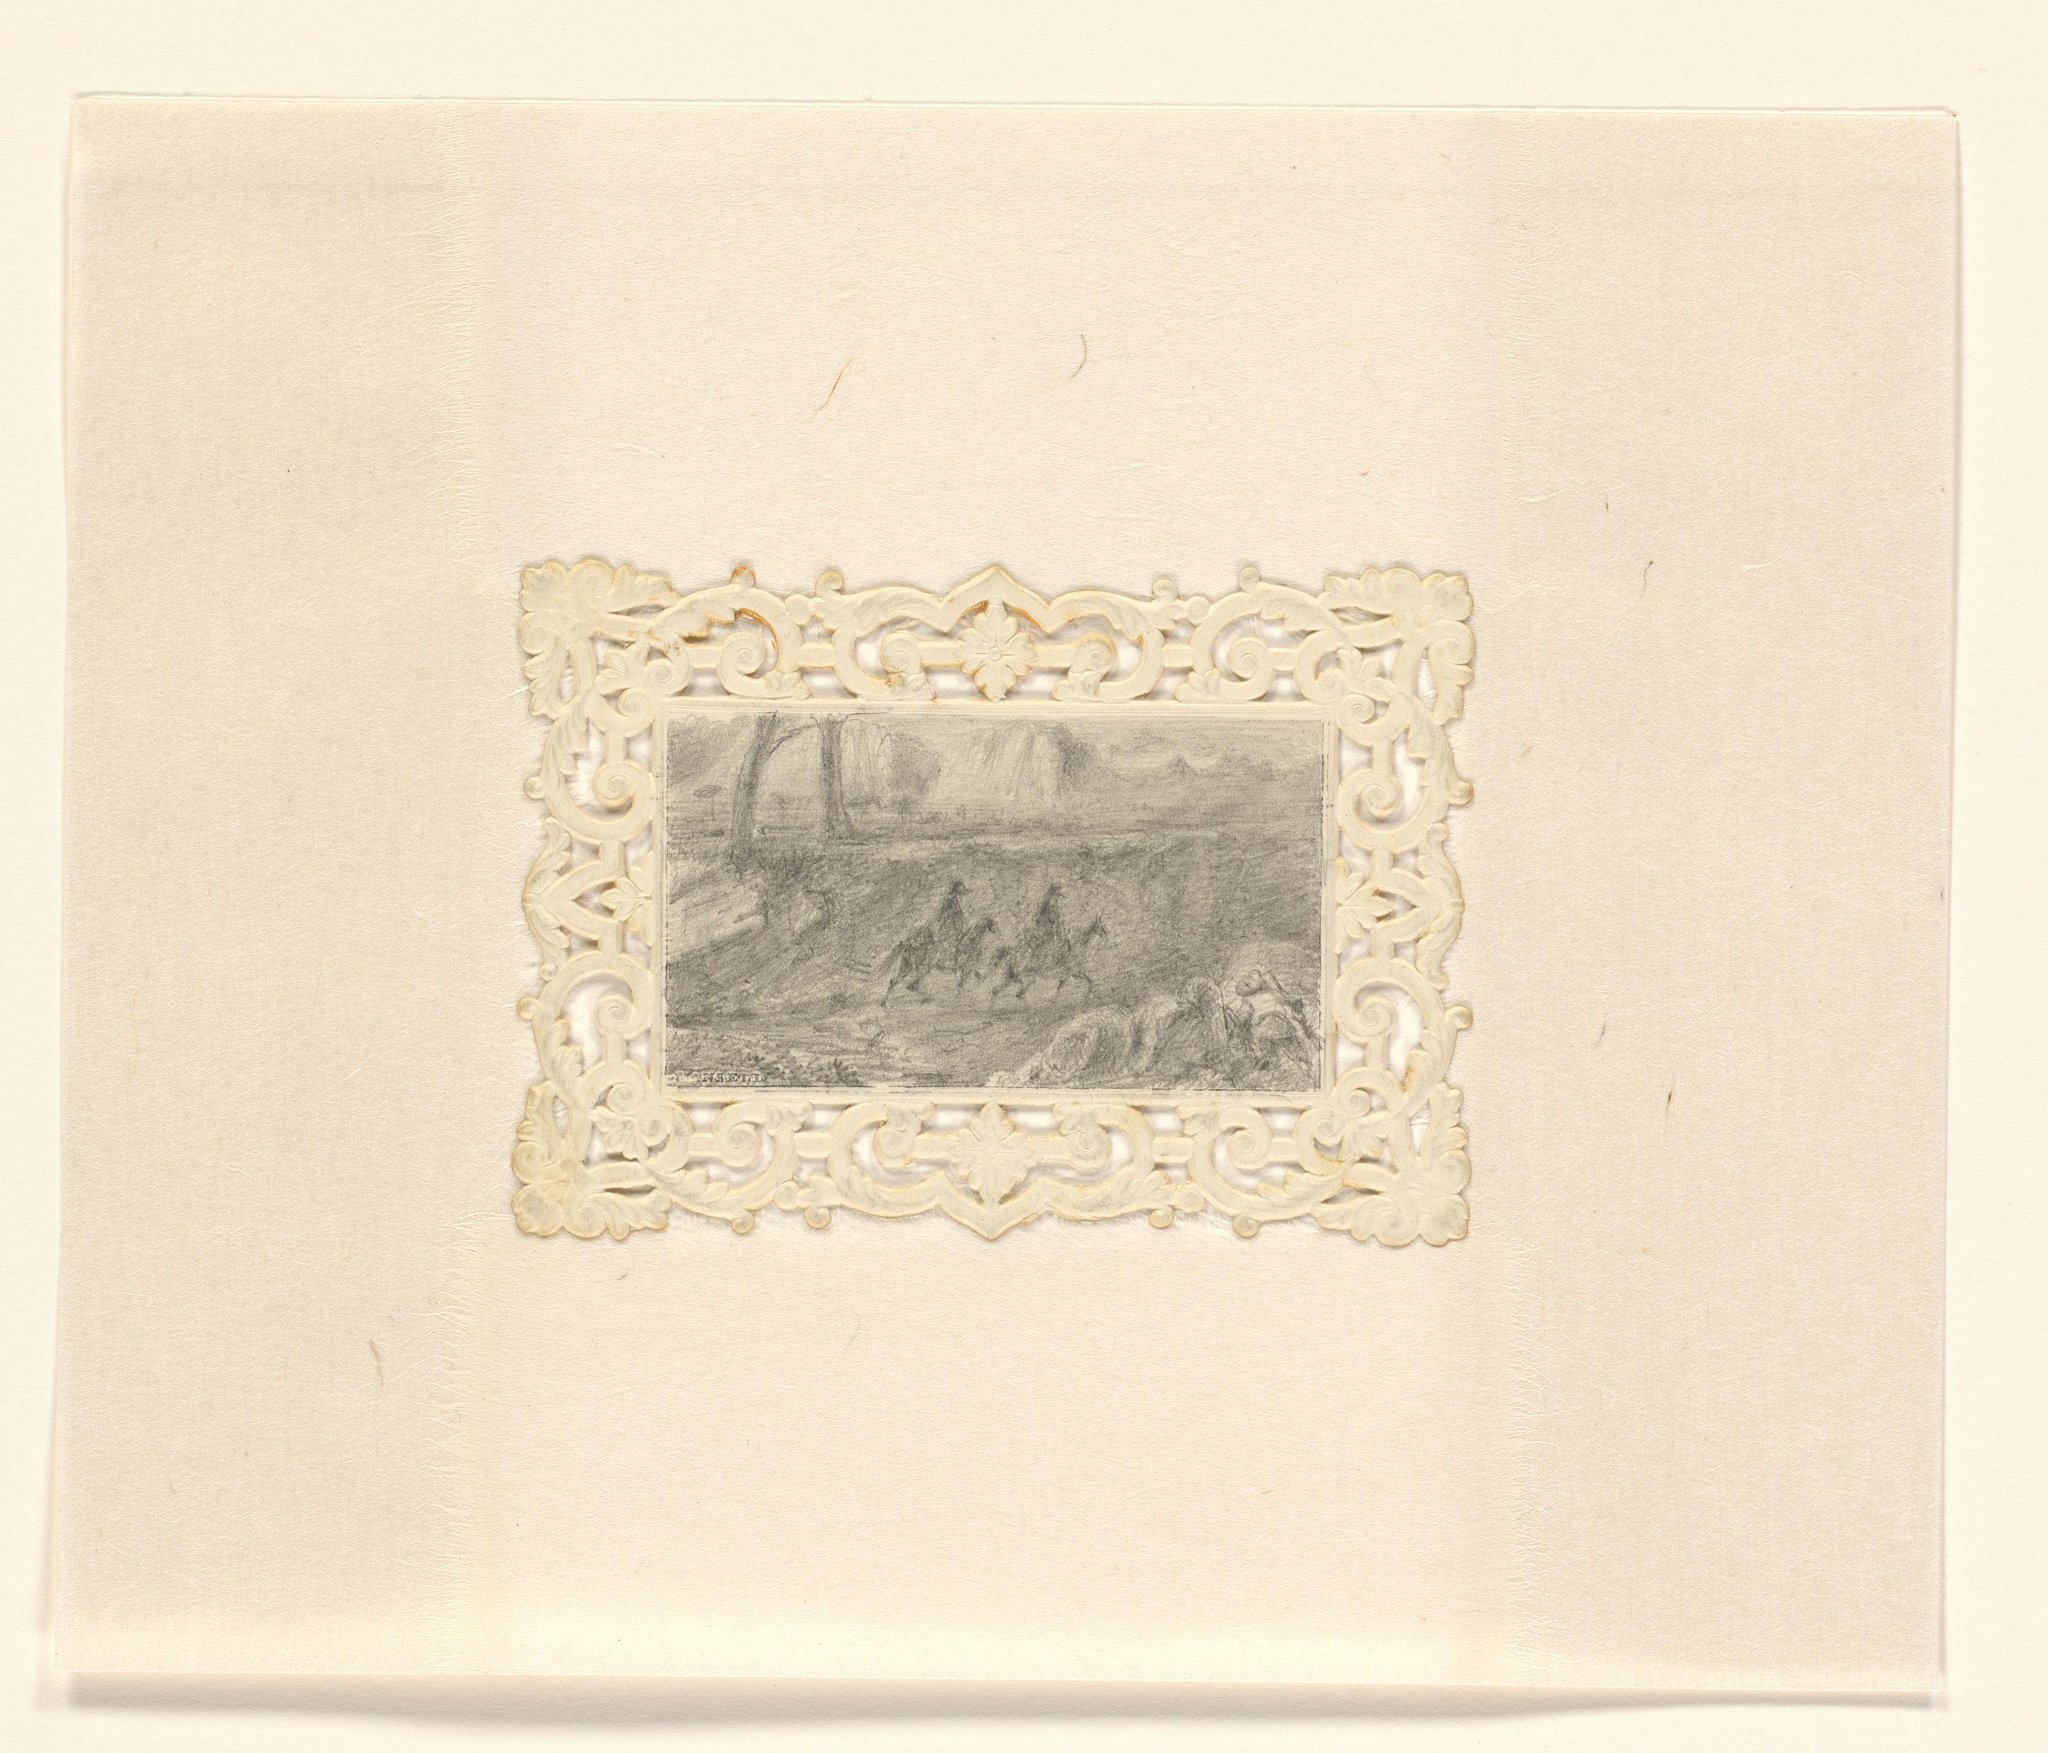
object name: drawing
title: Twee ruiters in een landschap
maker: louis charles hora siccama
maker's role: draughtsman, print maker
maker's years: 1807-1880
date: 1817-1880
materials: paper, pencil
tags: riding a horse, ass, or mule; rider, horseman, landscapes (+ landscape with figures, staffage)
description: Op de voorgrond een man in het struikgewas, mogelijk een jager. Tekening op een blad met gestanste ornamentrand.